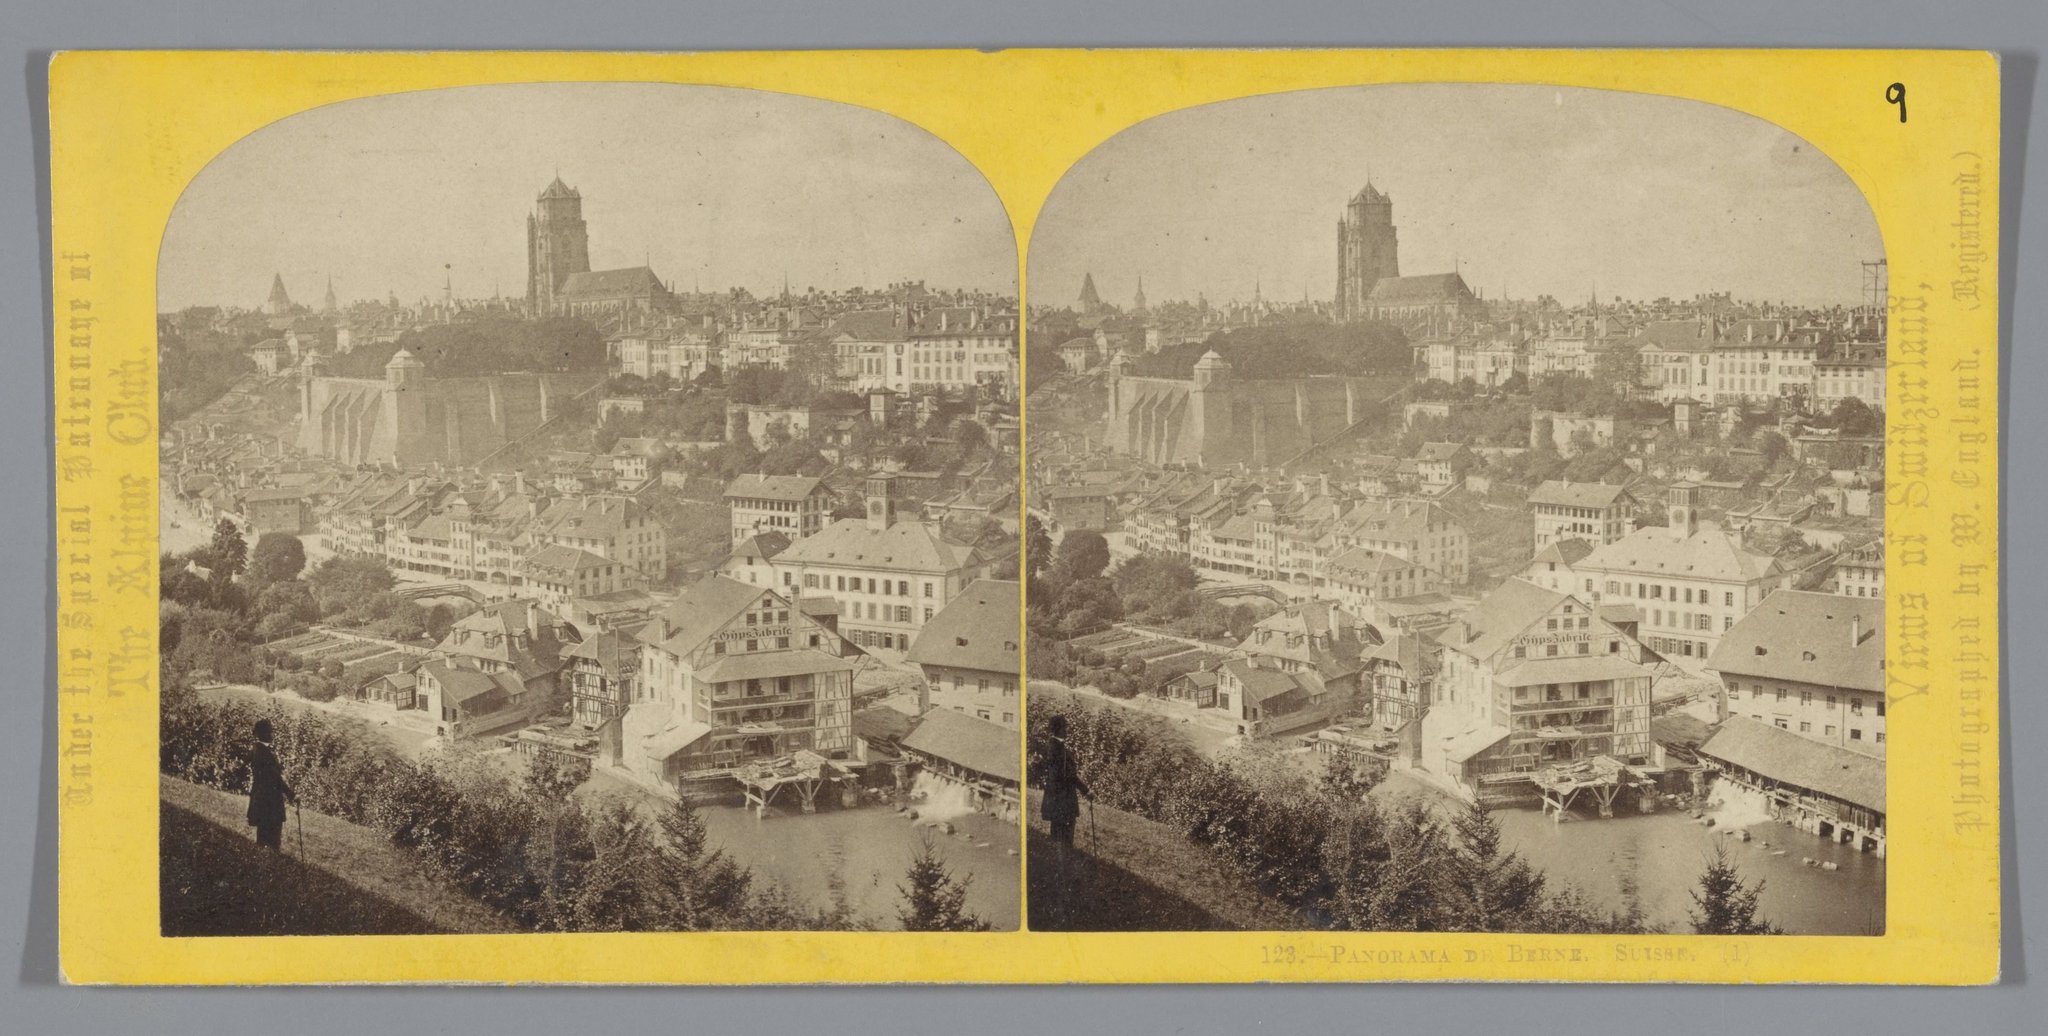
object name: stereograph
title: Panorama de Berne. Suisse. (1)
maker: william england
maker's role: fotograaf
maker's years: 1816-1896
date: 1850-1880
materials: cardboard, photographic support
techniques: albumen print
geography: bern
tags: city-view in general; 'veduta'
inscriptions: number: ‘123.’, number: ‘9’, inscription: ‘Views of Switzerland, photographed by W. England. (Registered) Under the Special Patronage of the Alpine Club.’